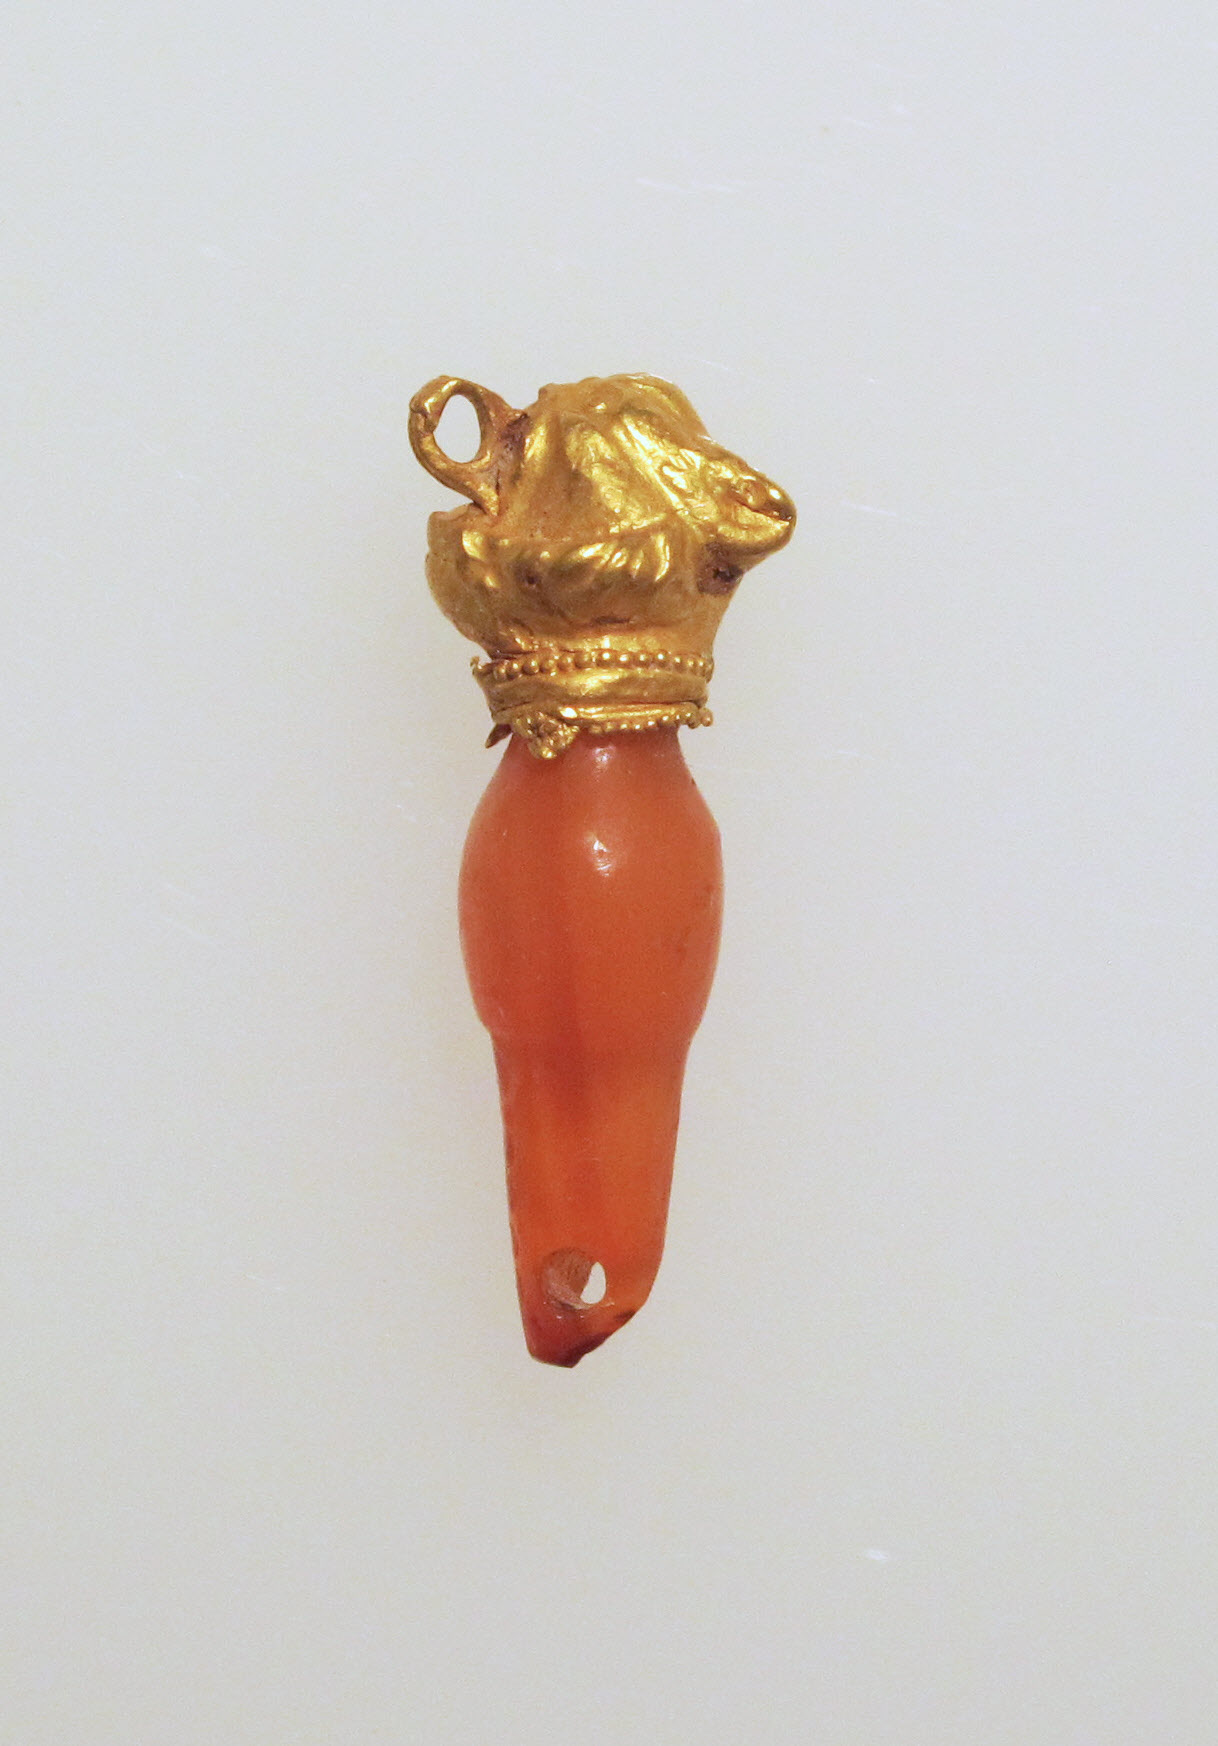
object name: pendant with goat's head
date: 7000 BCE-330 CE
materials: gold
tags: goats